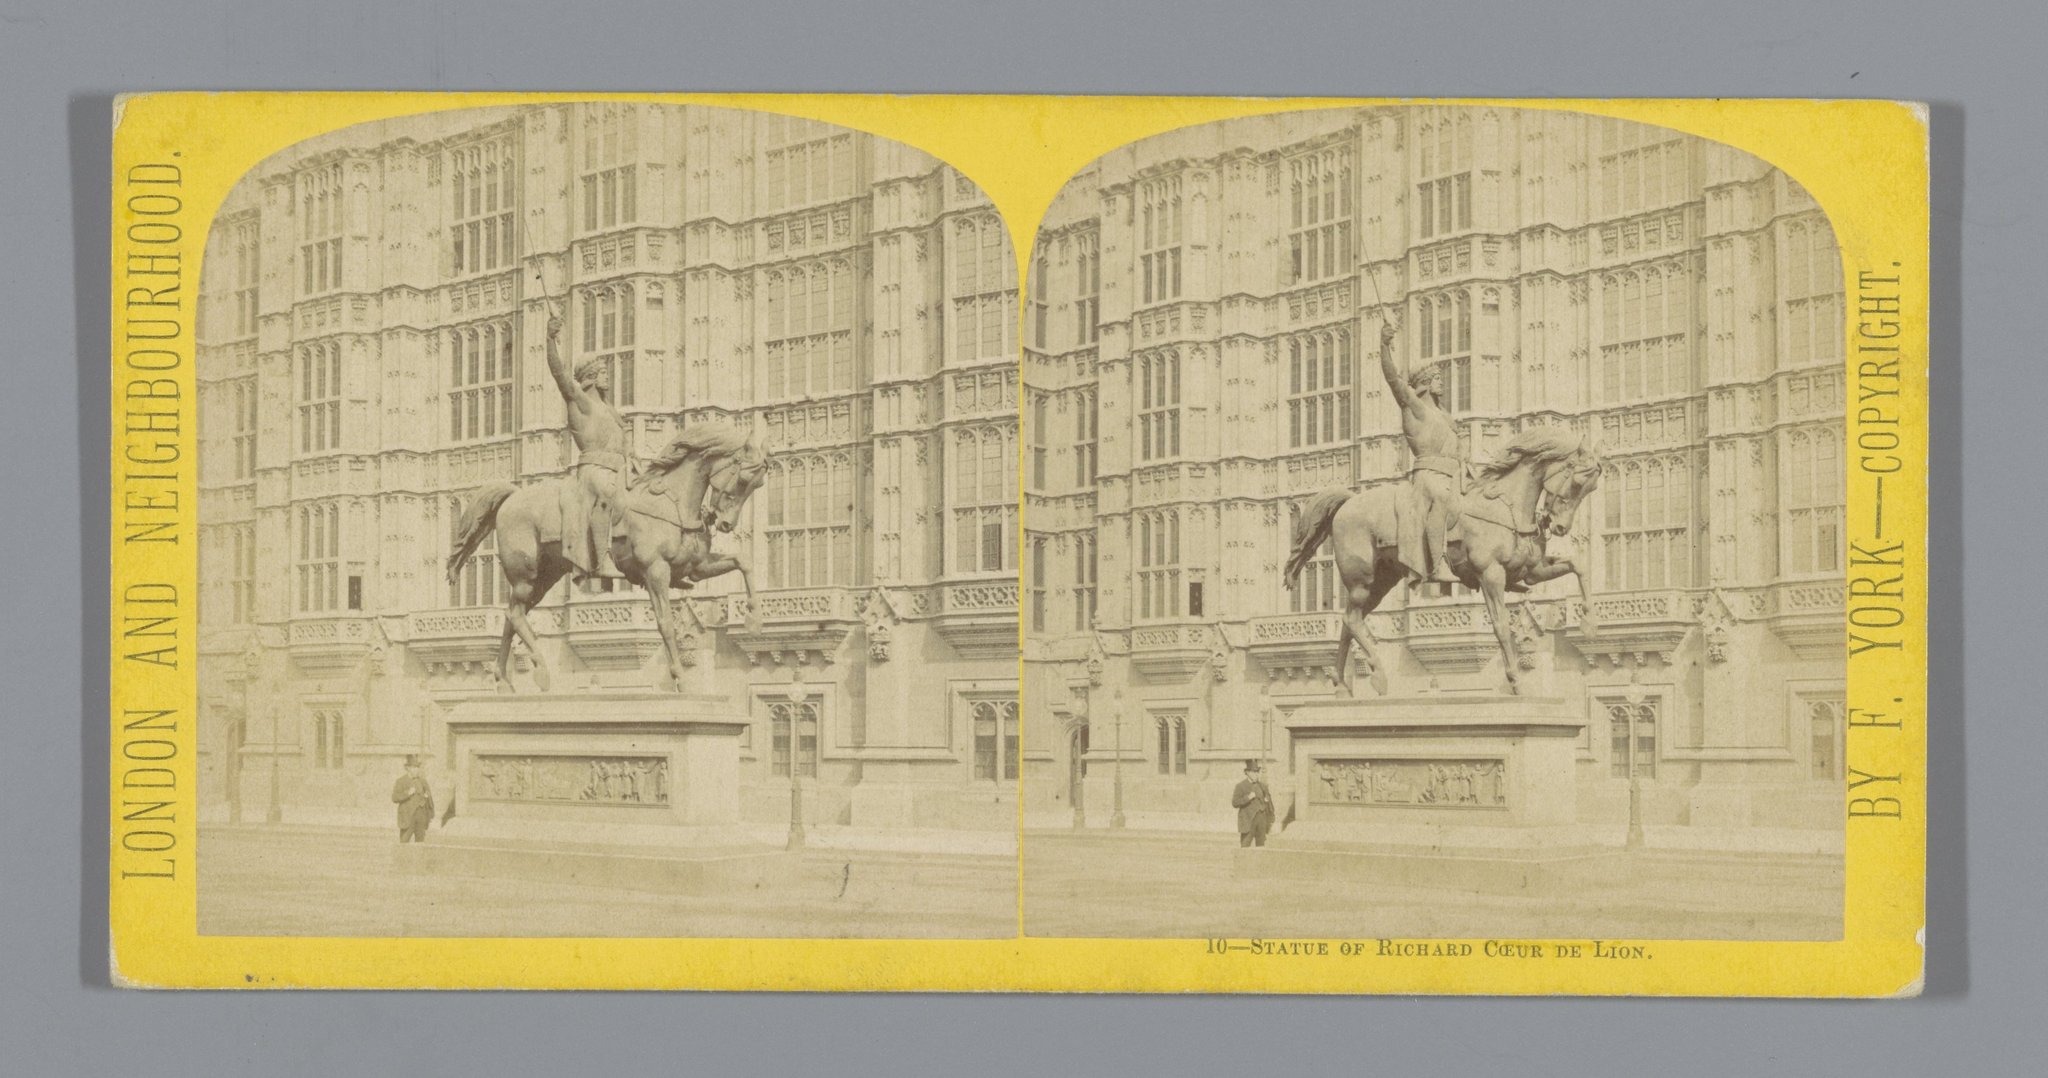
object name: stereograph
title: Statue of Richard Coeur de Lion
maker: frederick york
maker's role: fotograaf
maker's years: 1823-1903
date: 1860-1880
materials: cardboard, photographic support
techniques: albumen print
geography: london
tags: monument, statue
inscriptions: number: ‘10’